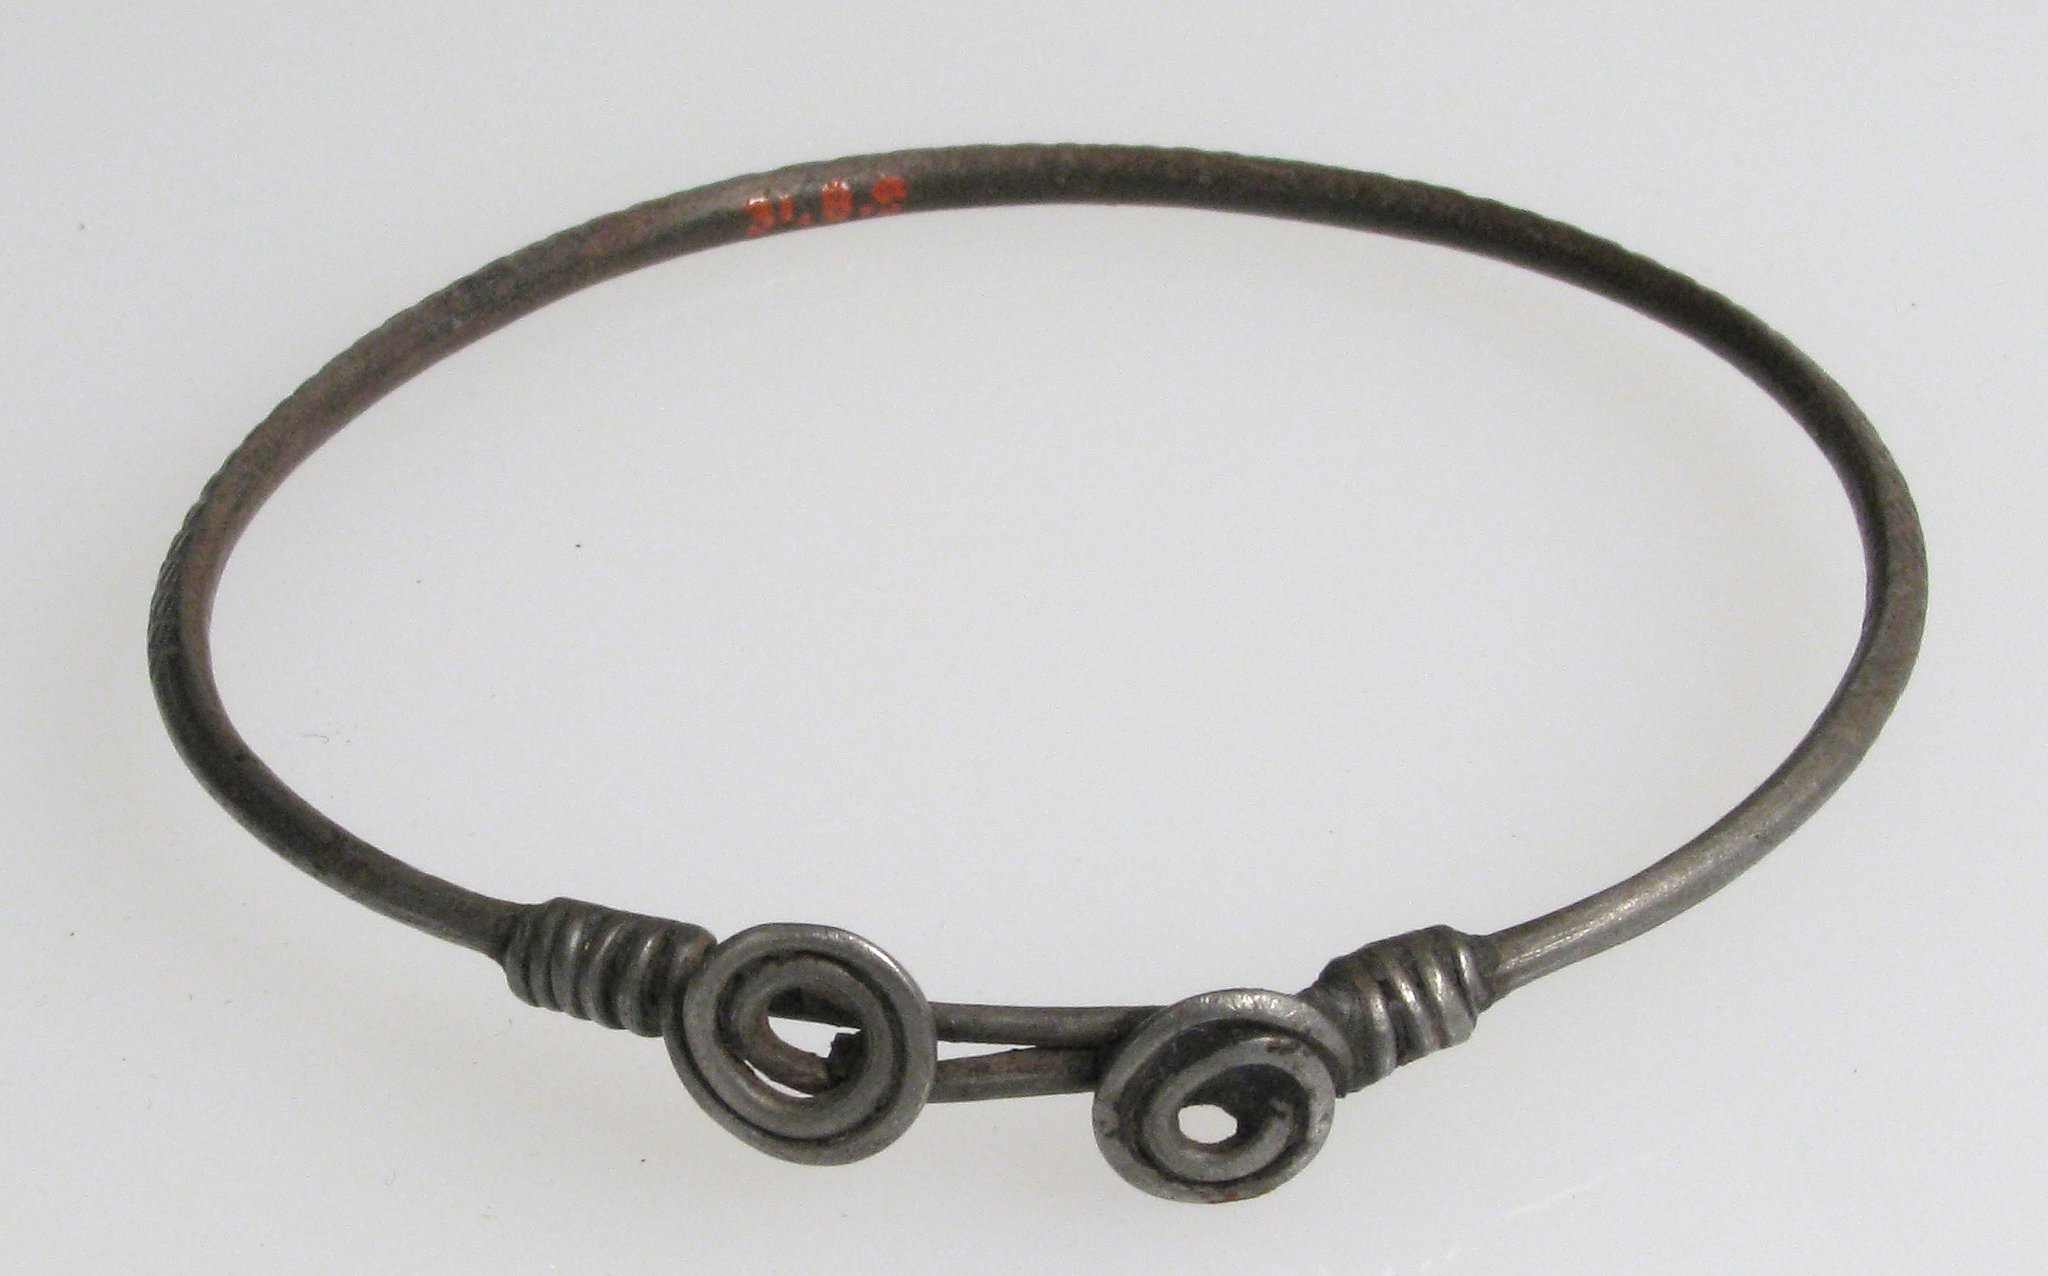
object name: bracelet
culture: coptic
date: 301-700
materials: iron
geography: egypt